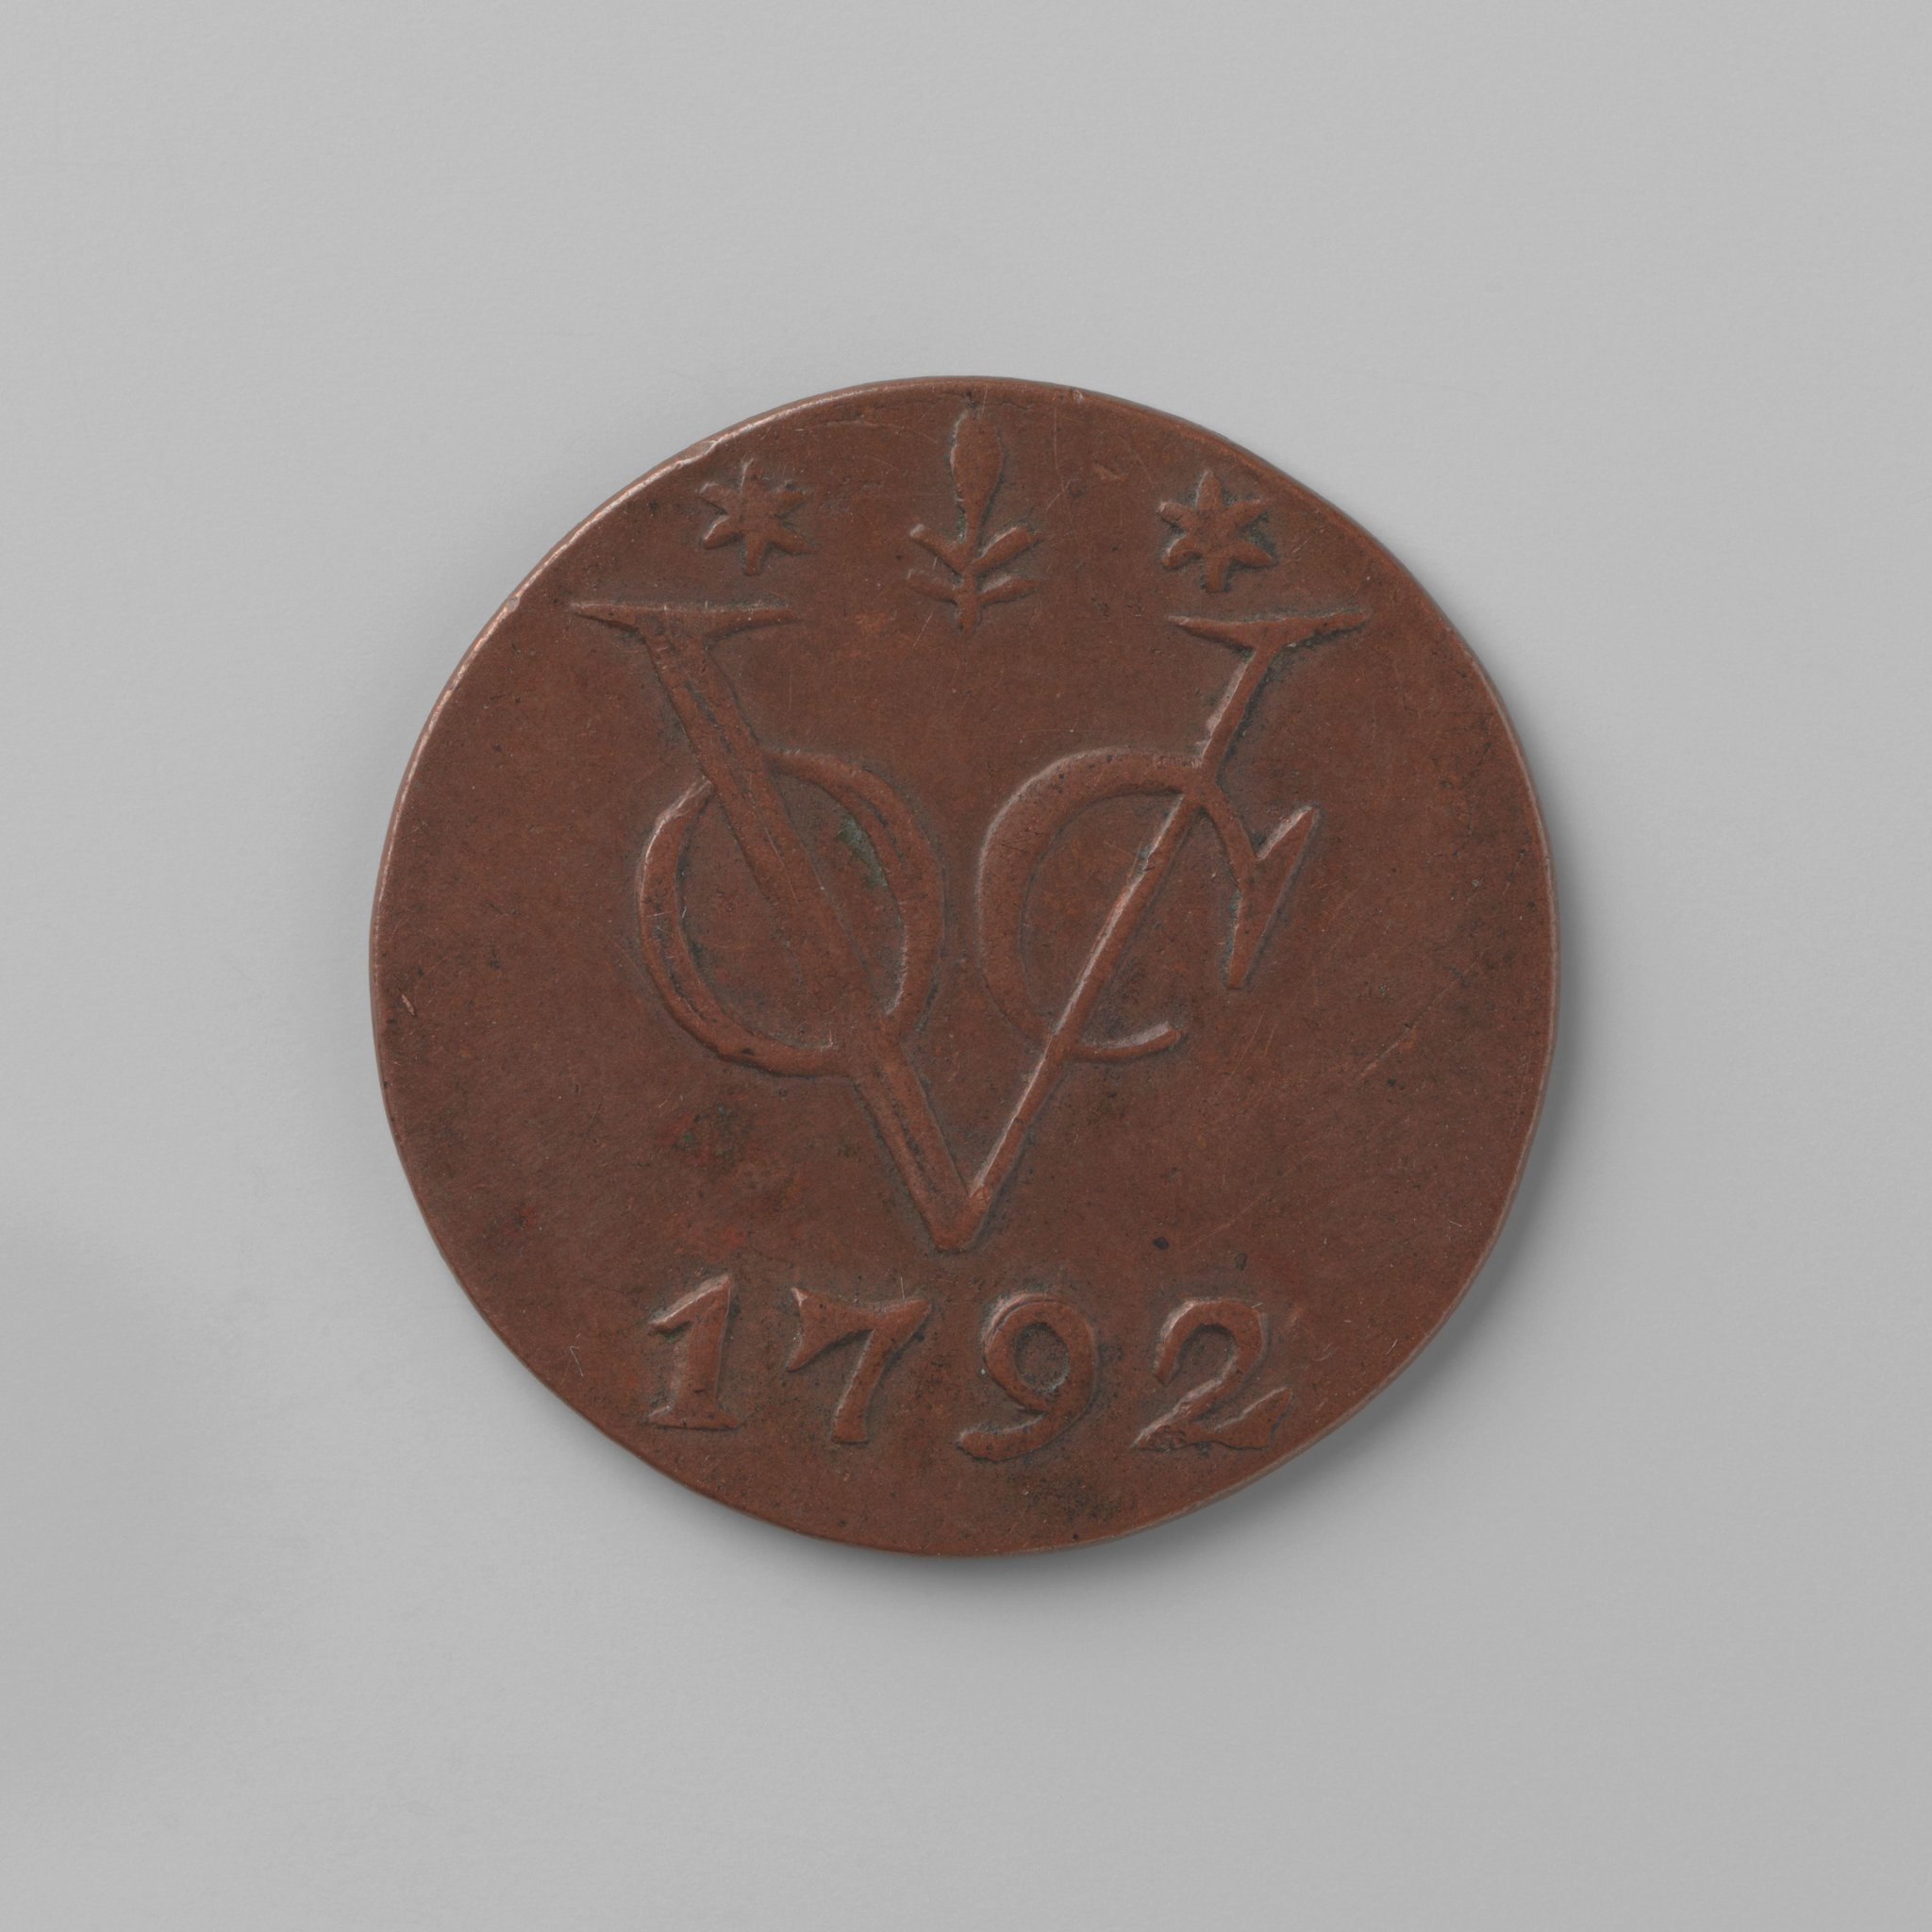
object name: coin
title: VOC, duit Gelderland,1792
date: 1792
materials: copper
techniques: striking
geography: harderwijk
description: Koperen munt. Voorzijde: tussen wapenspreuk gekroond wapenschild van Gelderland. Keerzijde: monogram van de VOC, waarboven muntmeesterteken en waaronder jaartal. Gladde rand.